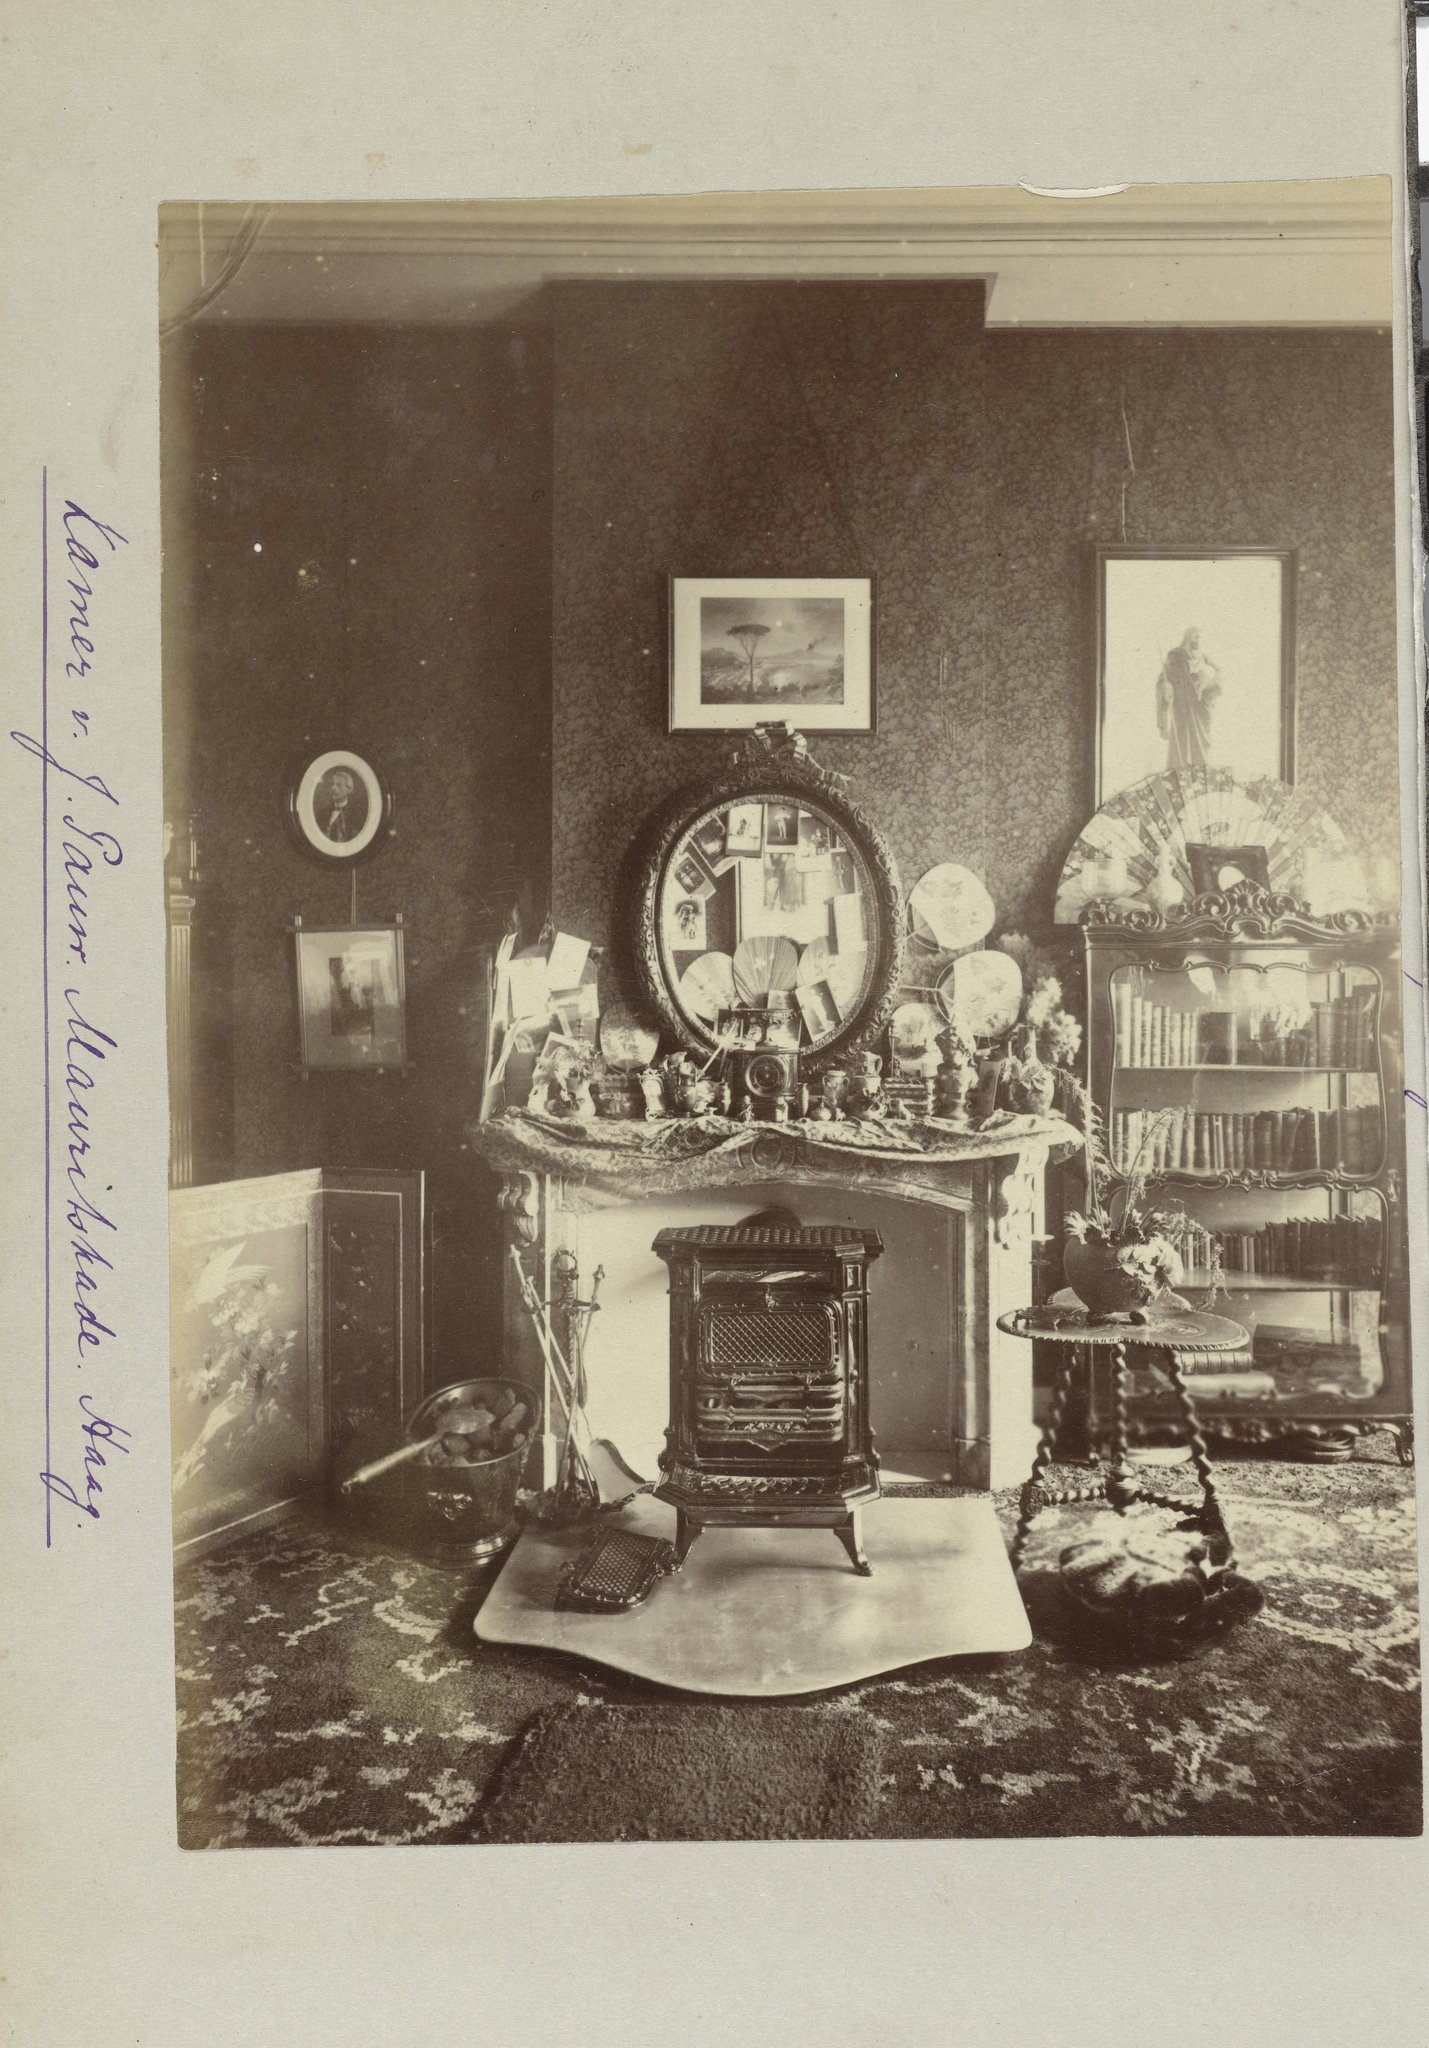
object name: photograph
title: Student Rooms of Pauw van Wieldrecht’s Friends in Utrecht and The Hague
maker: henry pauw van wieldrecht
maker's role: fotograaf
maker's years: 1863-1912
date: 1889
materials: paper, photographic support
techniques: albumen print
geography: netherlands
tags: the hague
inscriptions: inscription: ‘Kamer v. J. Pauw Mauritskade Haag’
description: Pauw van Wieldrecht sometimes took part in photography exhibitions. The Rijksmuseum owns around four hundred of his photographs and various albums. The amount of work preserved is more than that of any other amateur of the late 19th century.